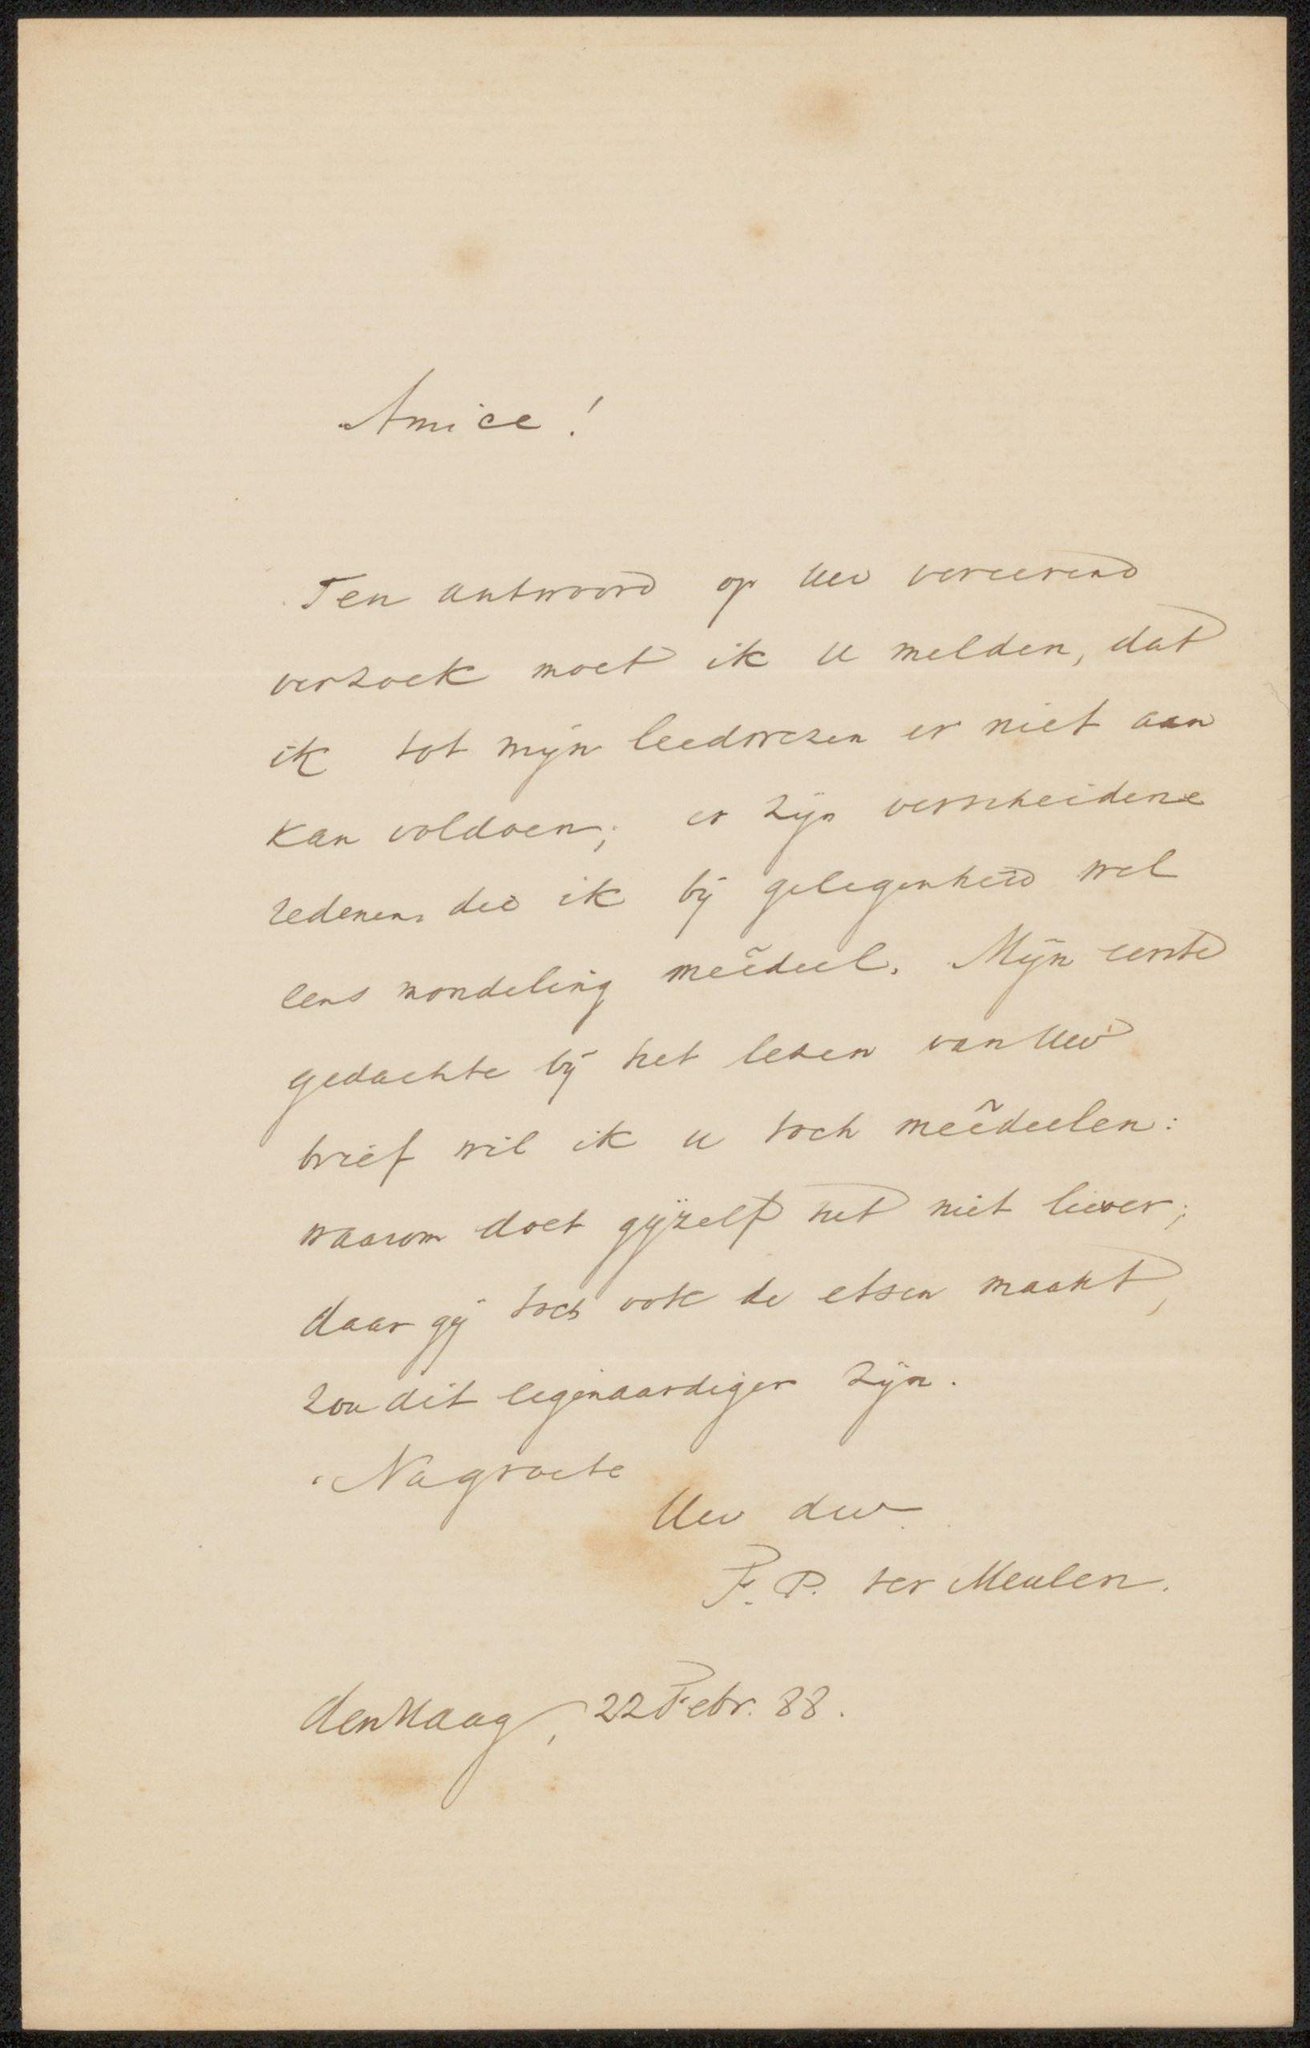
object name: letter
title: Brief aan Philip Zilcken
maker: françois pieter ter meulen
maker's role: painter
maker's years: 1843-1927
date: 1888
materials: ink, paper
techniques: pen, writing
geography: the hague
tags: philip zilcken, the graphic arts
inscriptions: collector's mark: ‘RPK’